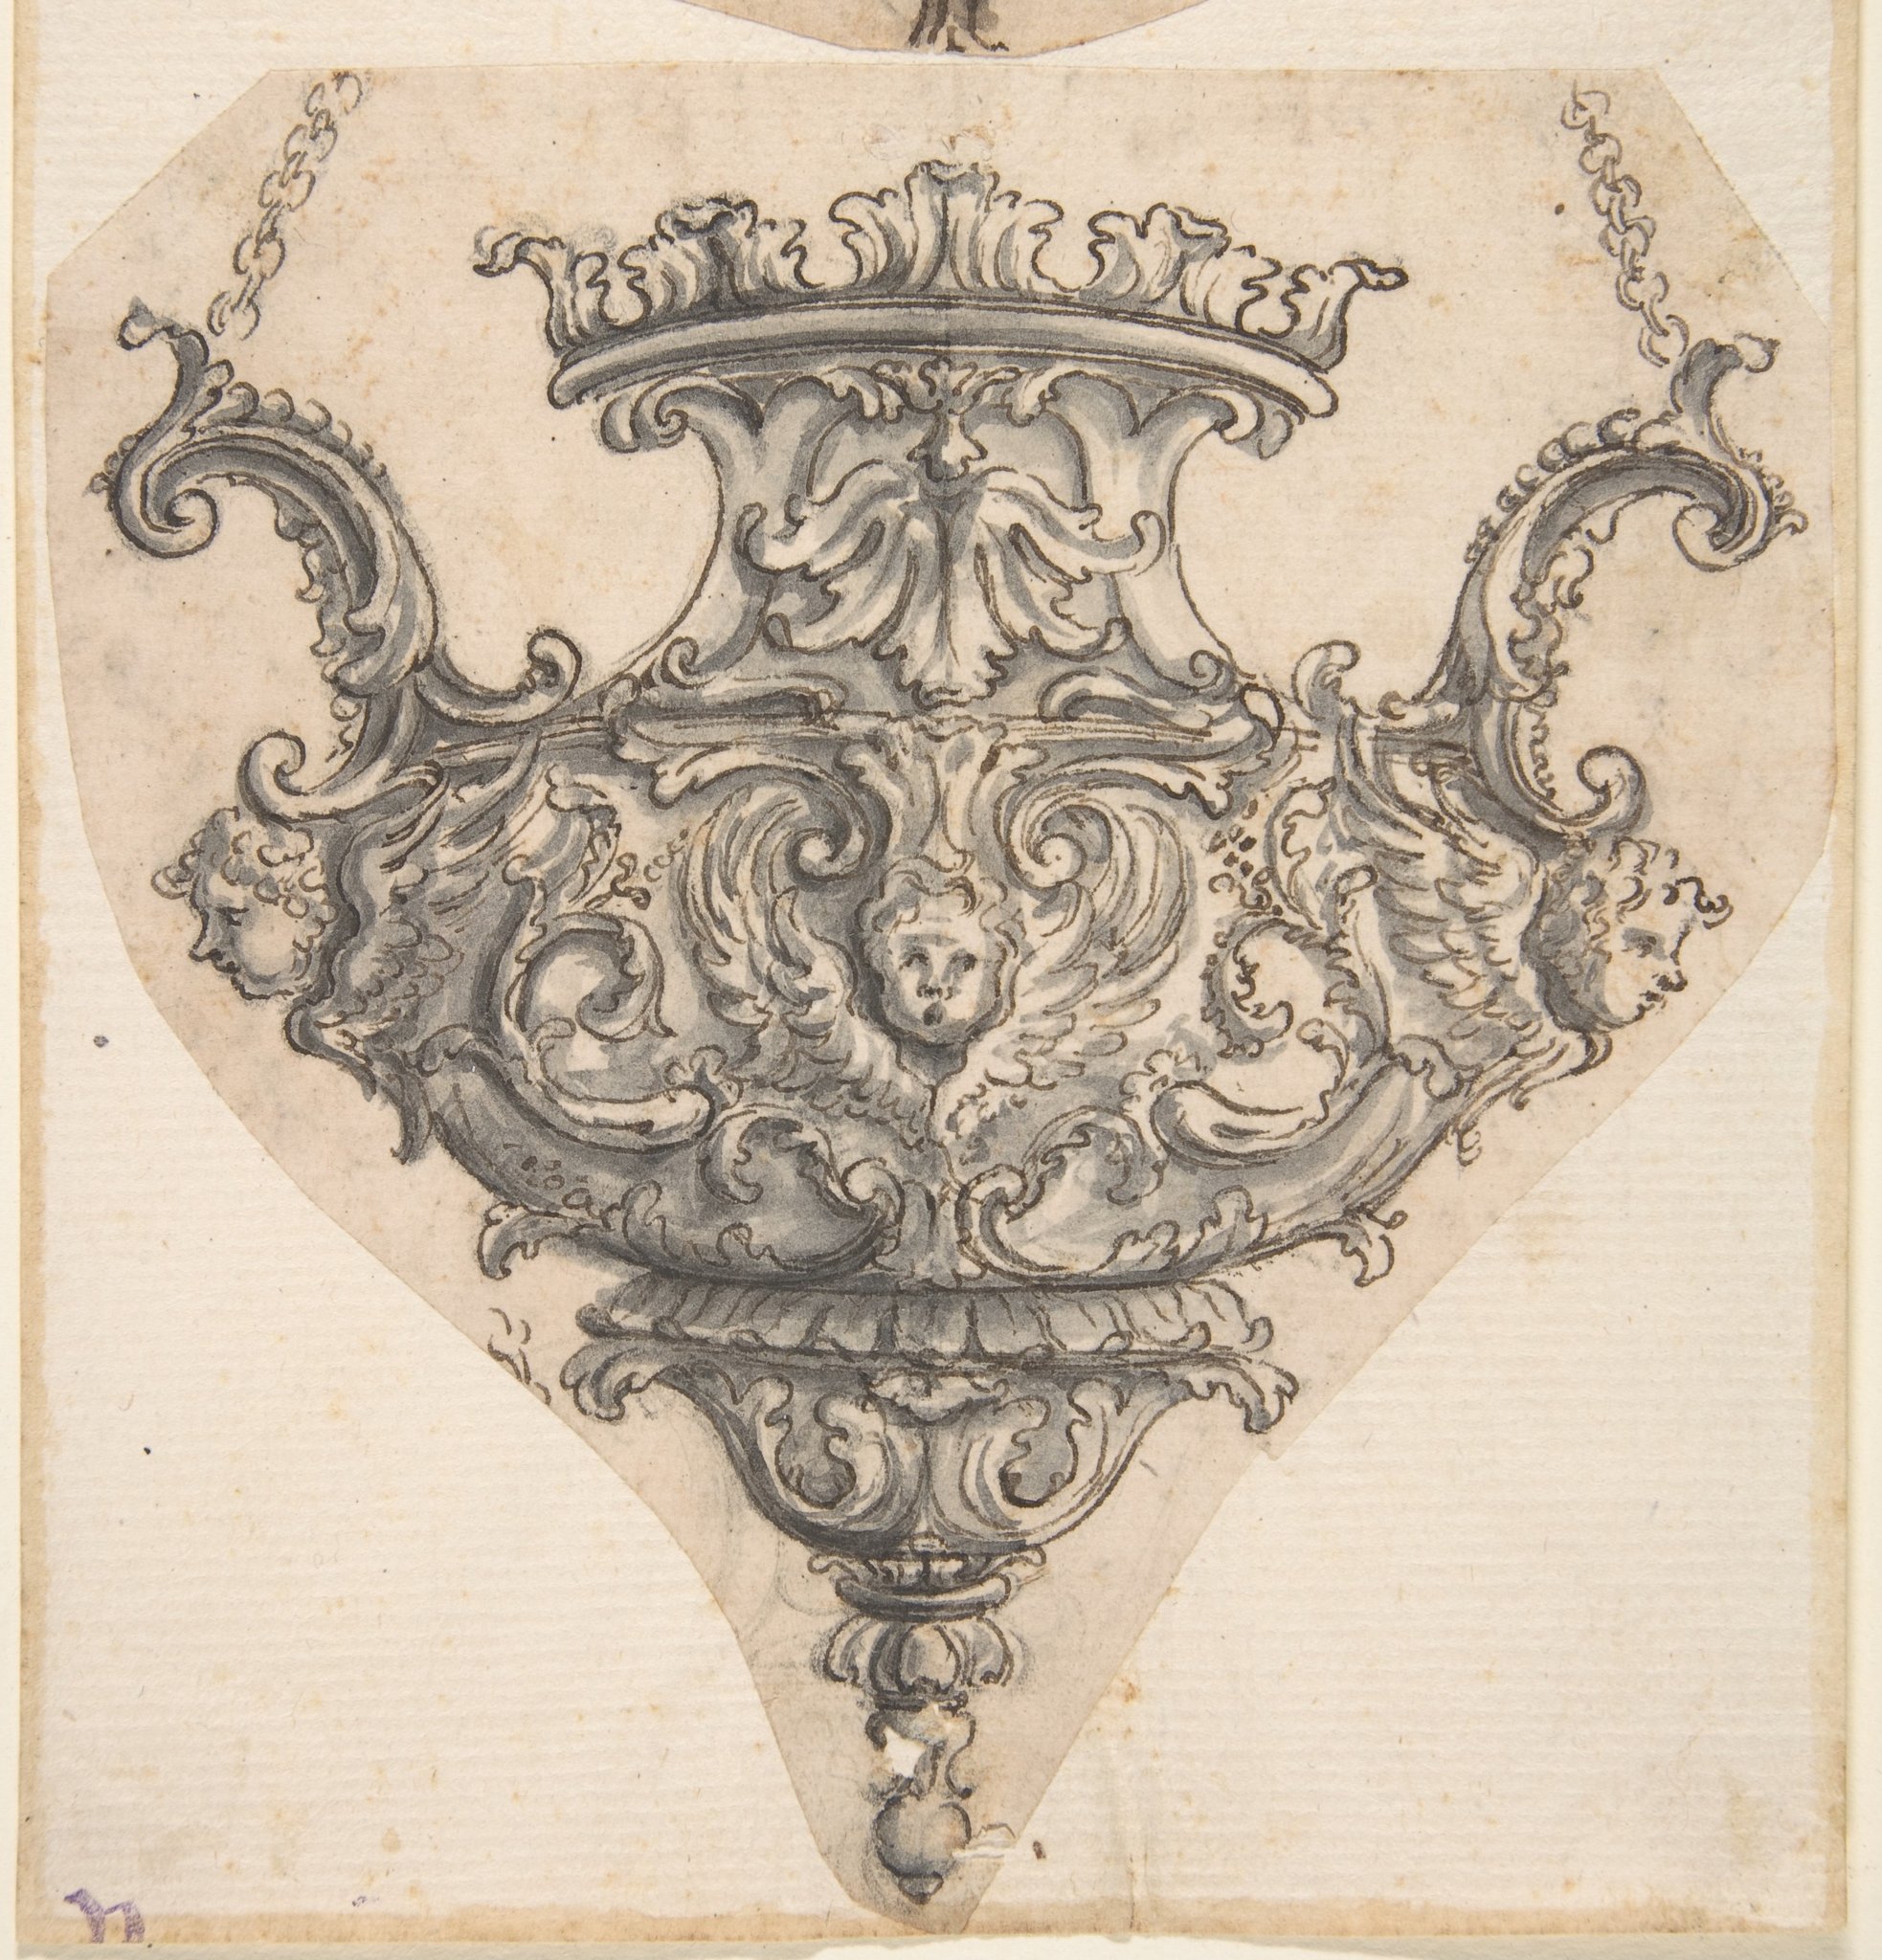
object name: drawing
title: Design for Suspended Censer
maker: giovanni battista foggini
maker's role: artist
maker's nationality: italian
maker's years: 1652-1725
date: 1672-1725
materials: chalk, ink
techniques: brush, pen, wash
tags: faces